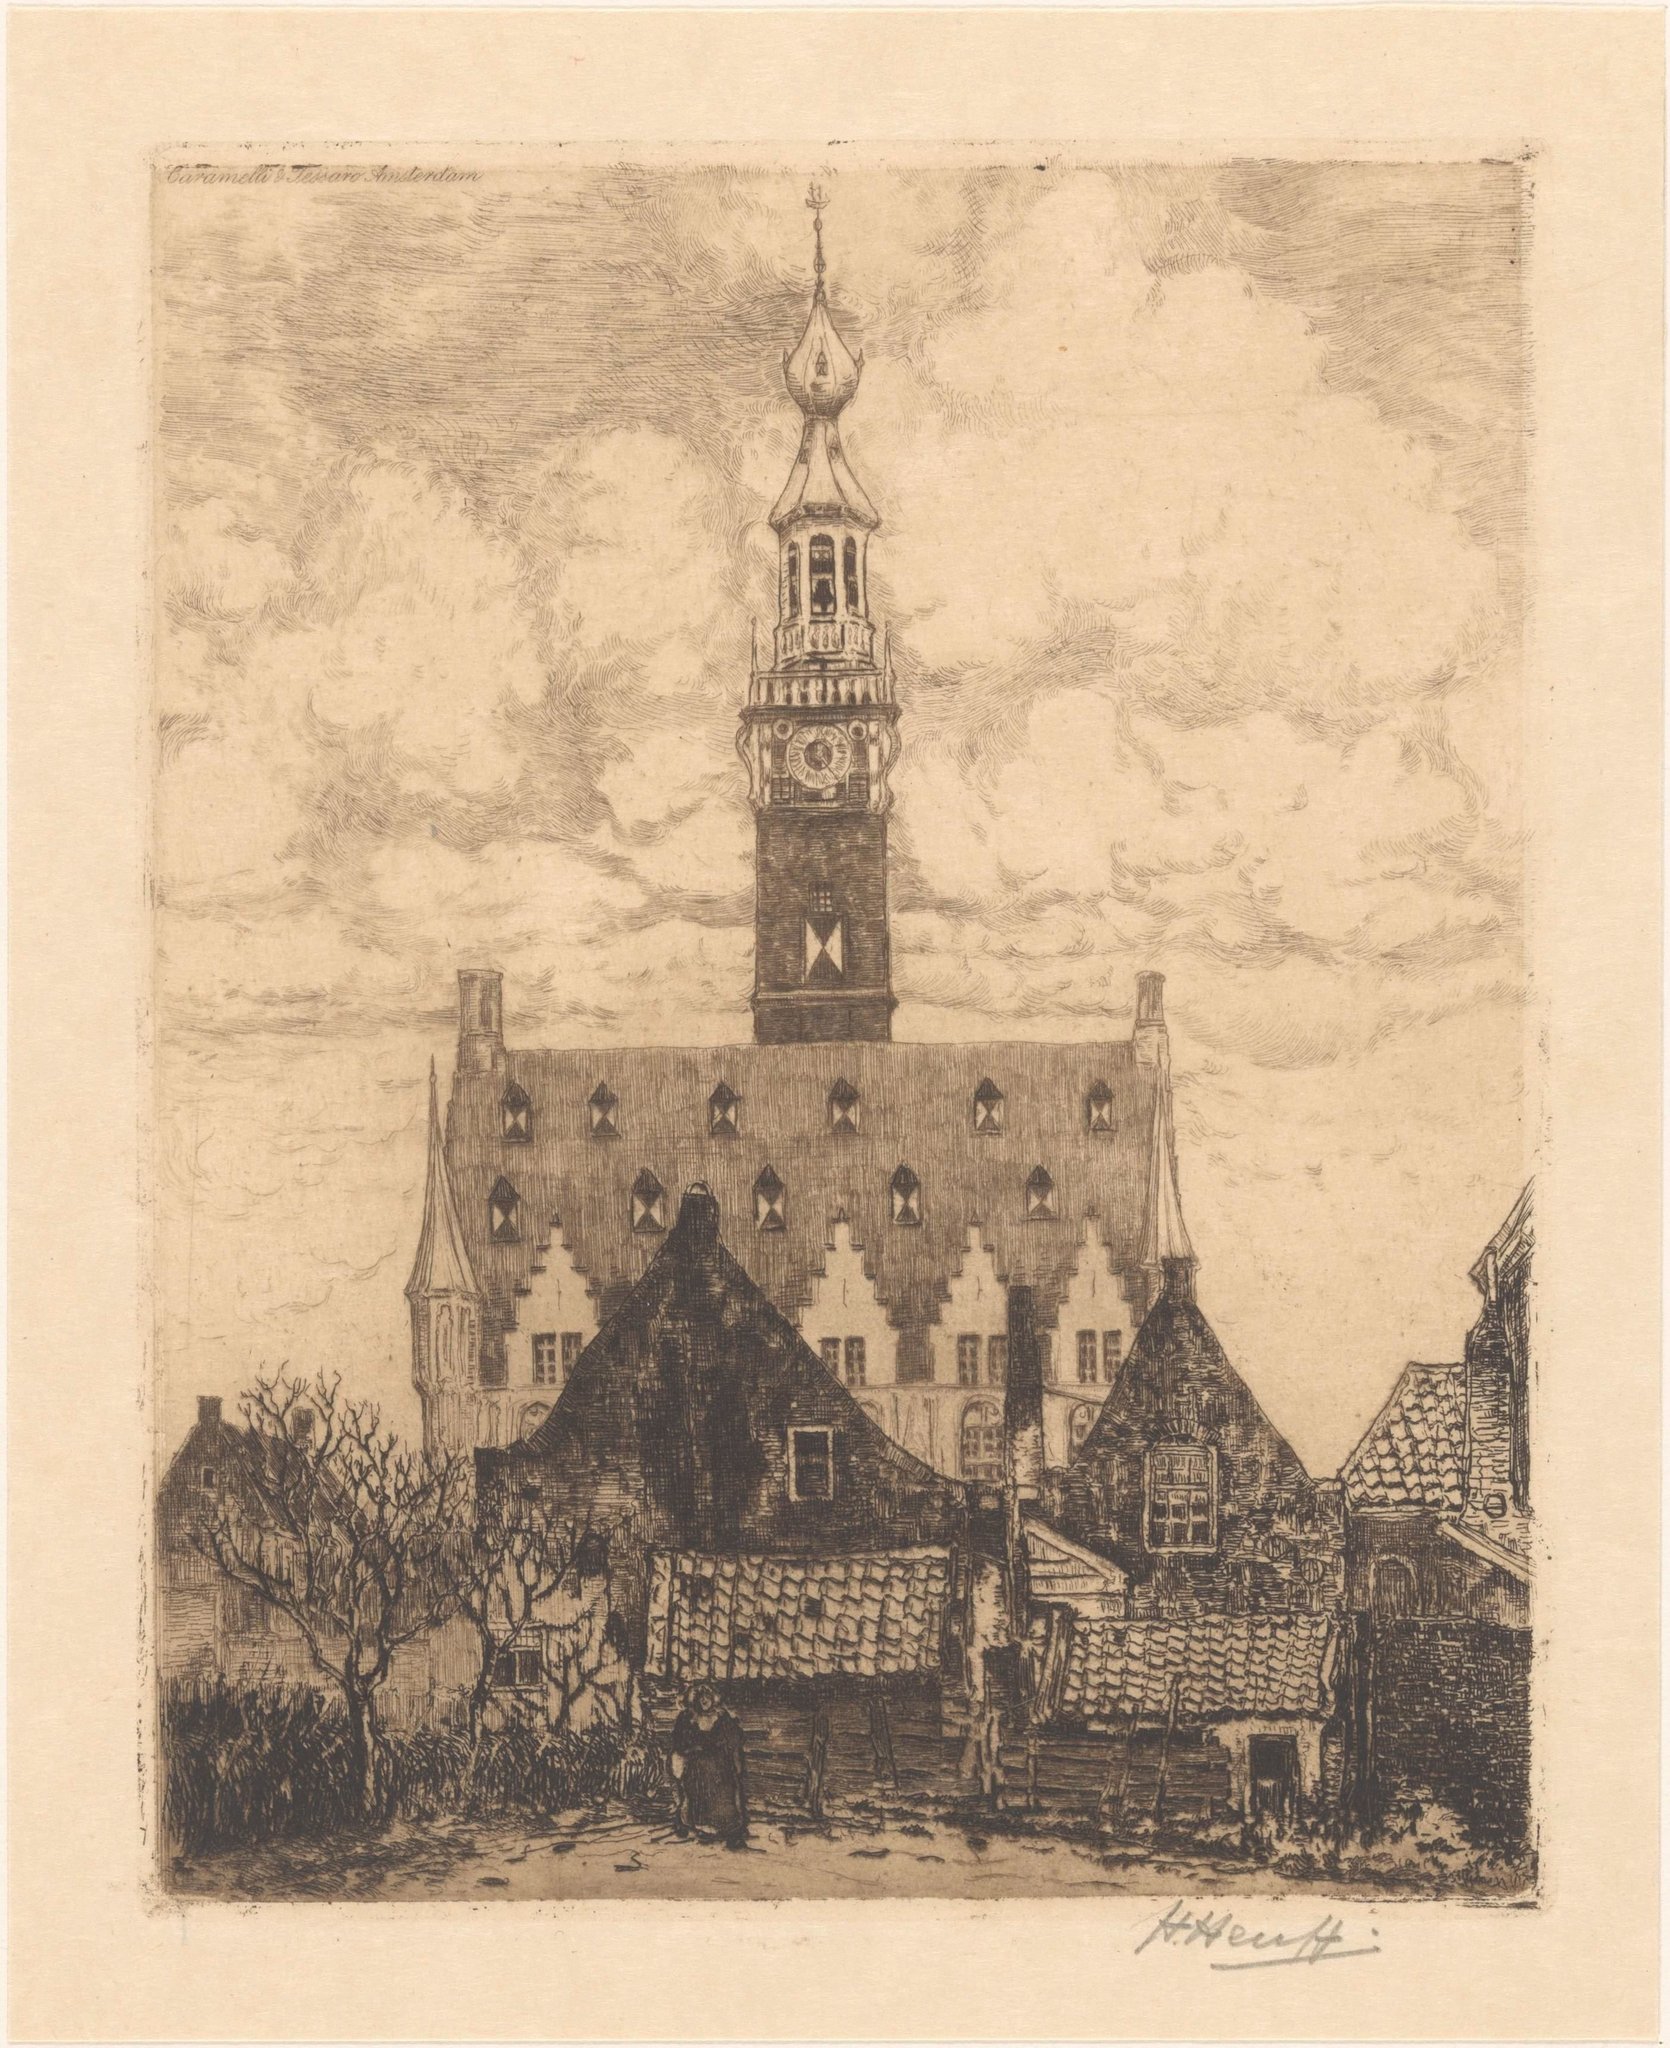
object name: print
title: Stadhuis in Veere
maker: herman heuff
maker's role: print maker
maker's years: 1875-1945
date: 1885-1926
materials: paper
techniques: etching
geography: amsterdam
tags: townhall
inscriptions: collector's mark: Lugt 2228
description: Op de voorgrond een vrouw bij een schuur.